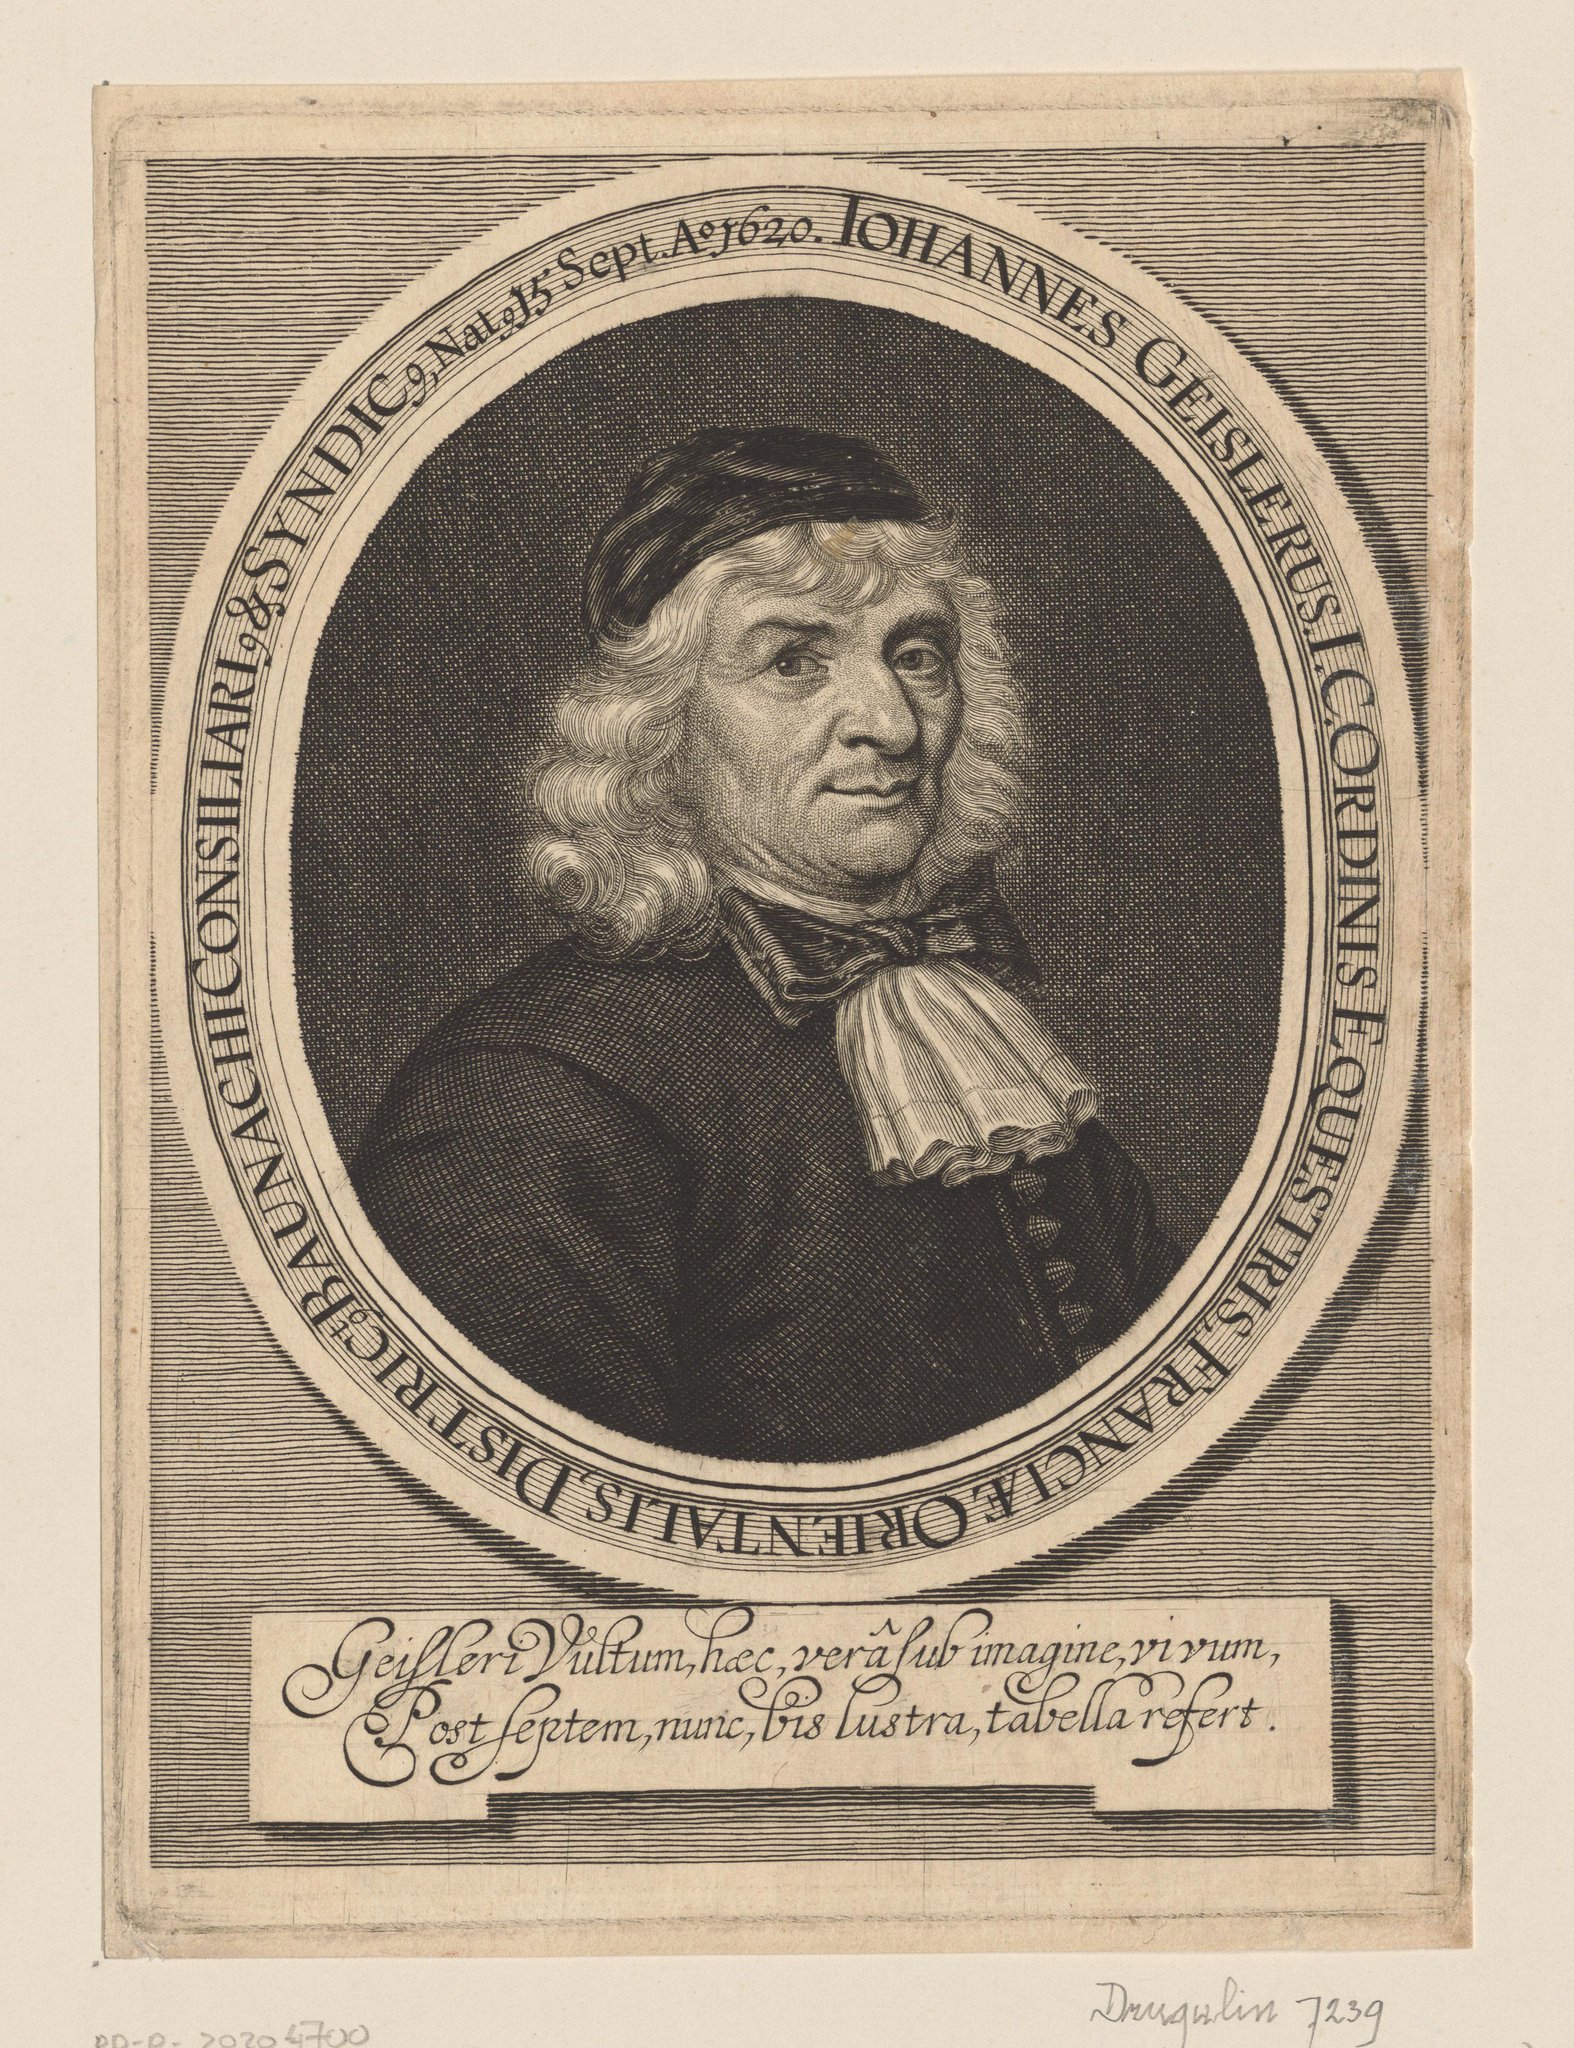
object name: print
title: Portret van Johann Geisler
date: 1654-1708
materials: paper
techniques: engraving, etching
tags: historical persons, lawyer, attorney at law